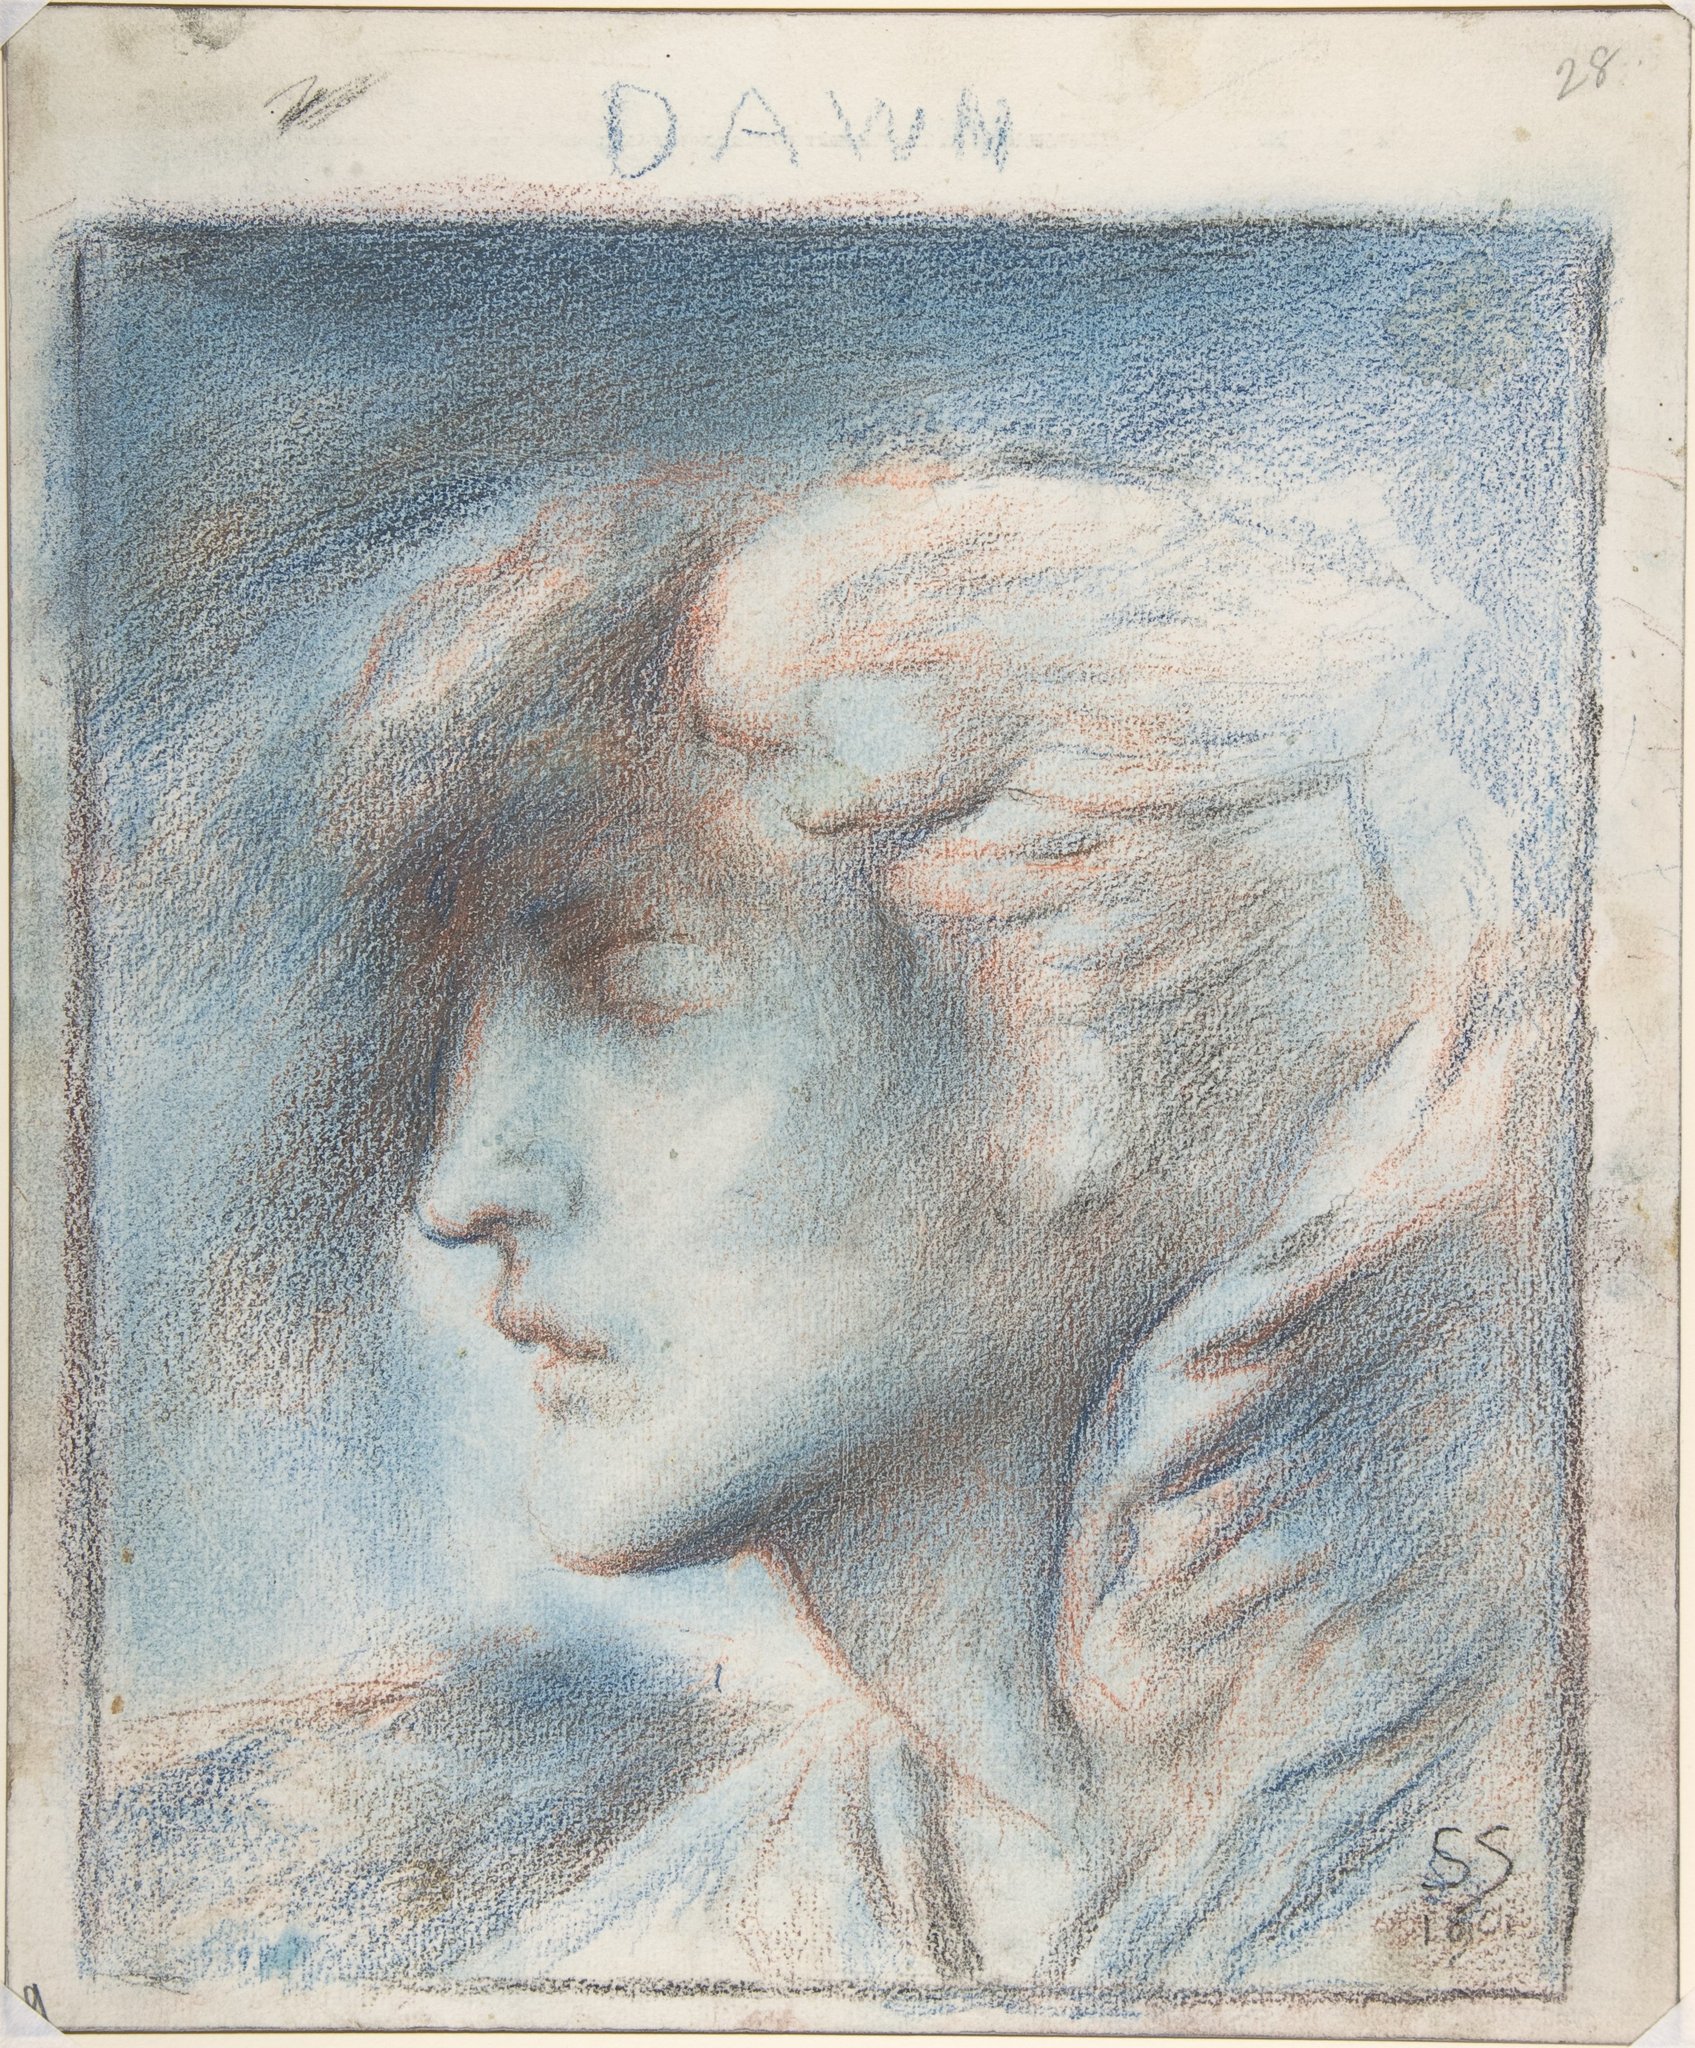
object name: drawing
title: Dawn (Head of Hypnos)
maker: simeon solomon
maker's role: artist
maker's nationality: british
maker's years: 1840-1905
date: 1901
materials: chalk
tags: mythology,heads